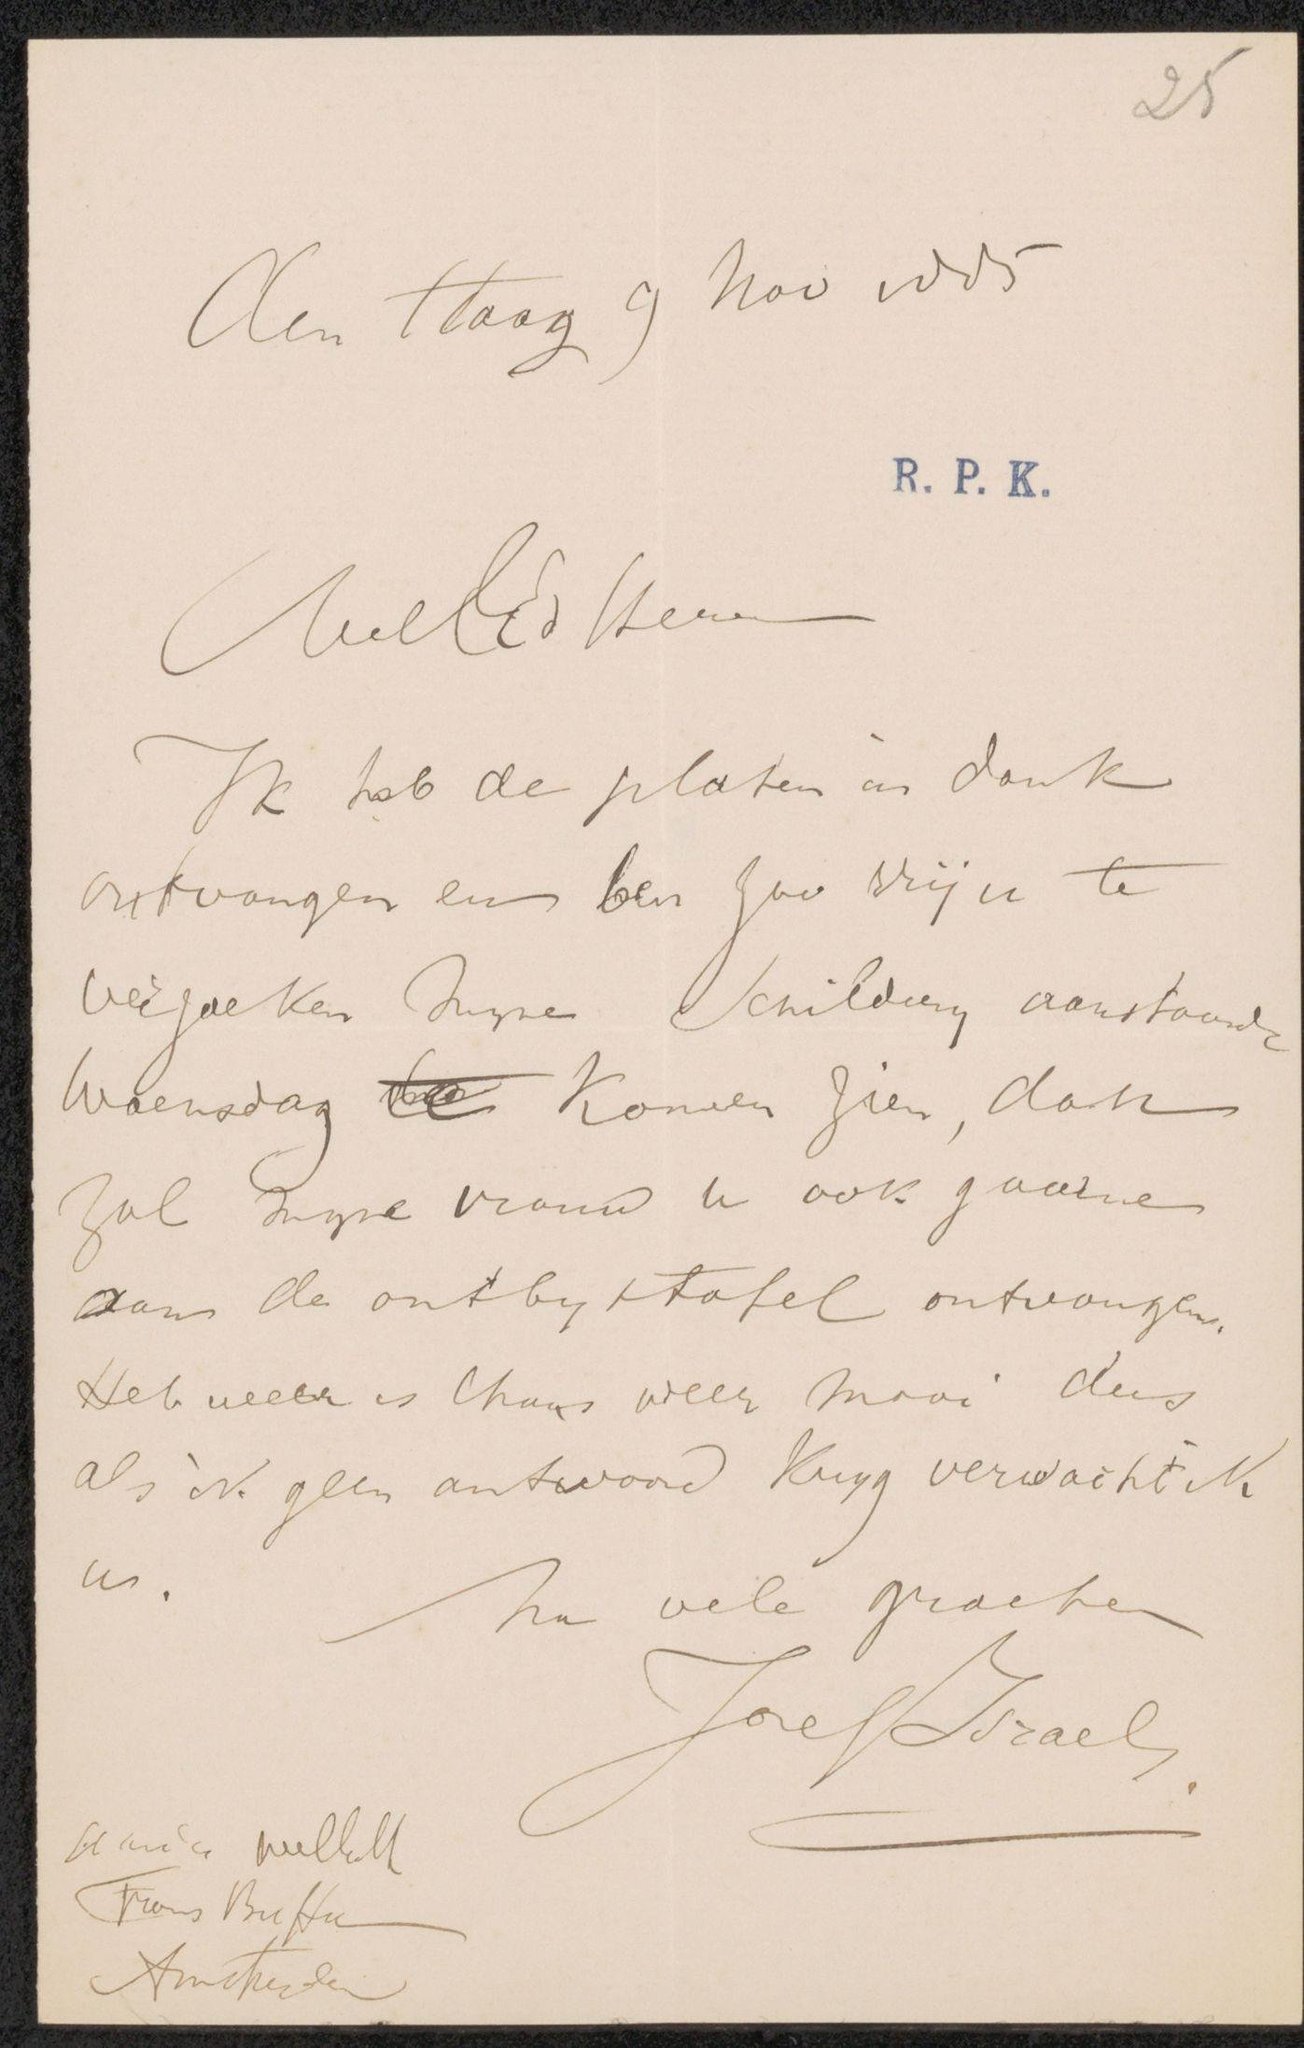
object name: letter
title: Brief aan Frans Buffa en Zonen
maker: jozef israëls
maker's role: draughtsman, painter, print maker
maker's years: 1824-1911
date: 1885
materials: ink, paper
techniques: pen, writing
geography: the hague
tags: publisher, the graphic arts, painting (including book-illumination, miniature-painting)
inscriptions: collector's mark: Lugt 2233